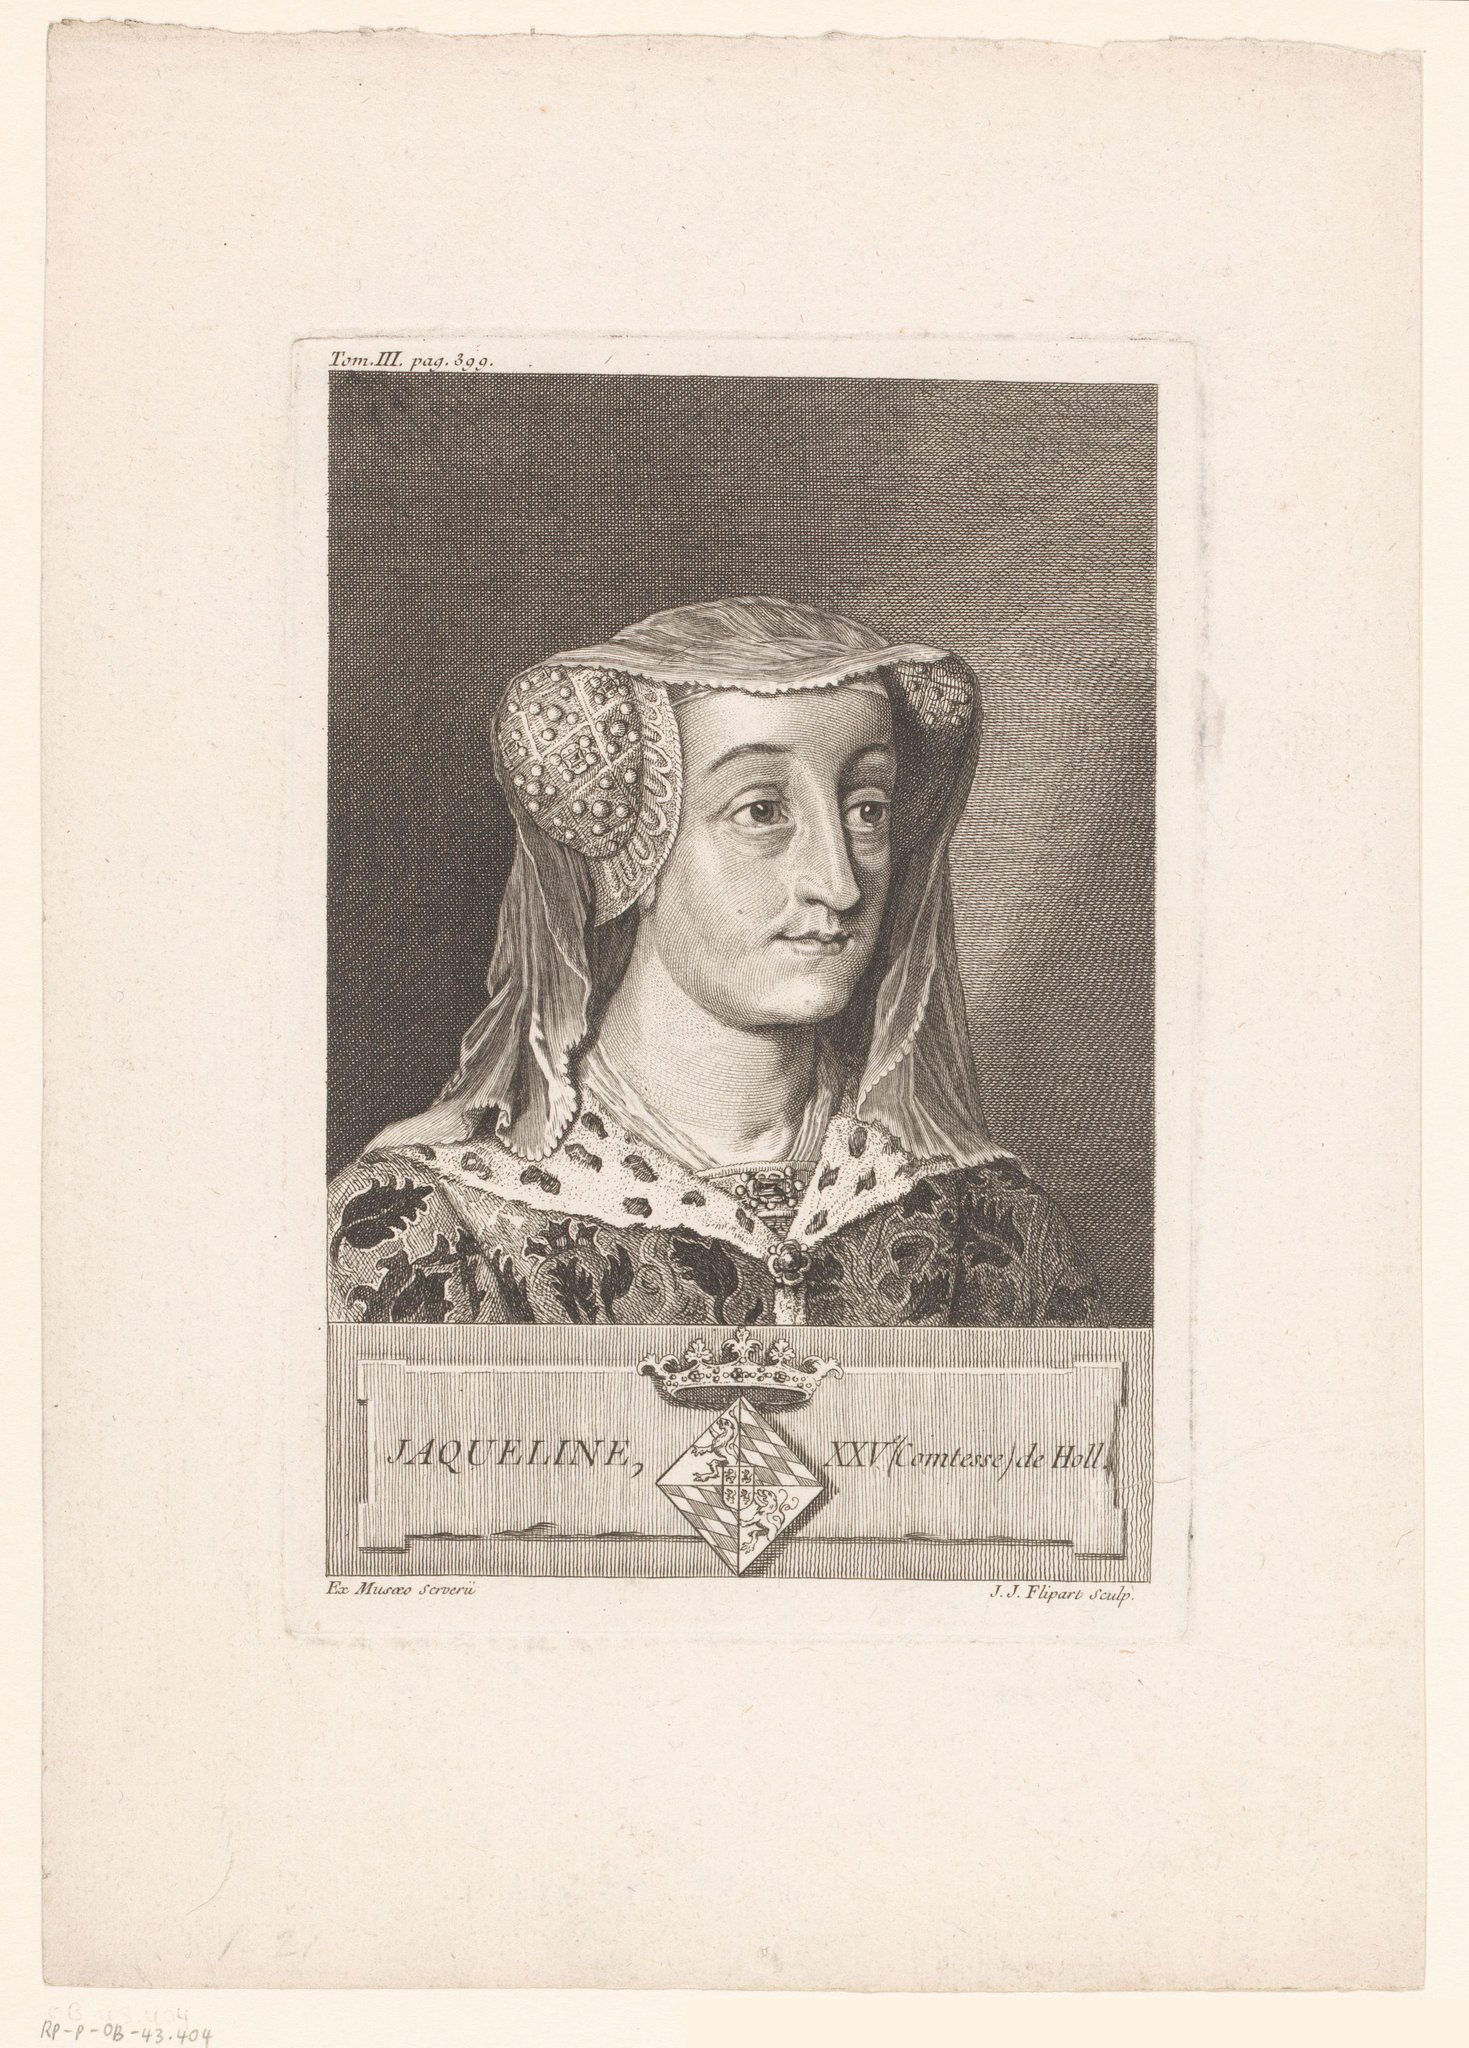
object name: book illustration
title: Jaqueline, XXVe (Comtesse) de Holl.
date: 1757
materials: paper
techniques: engraving, etching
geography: paris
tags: jacoba of bavaria (countess of hainaut), historical persons - bb - woman, ruler, sovereign - bb - female ruler, armorial bearing, heraldry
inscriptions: collector's mark: Lugt 2228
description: Prent uit: Sellius en Dujardin. Histoire générale des Provinces-Unies. Parijs: Pierre Guillaume Simon, 1757, dl. 3 p. 399.